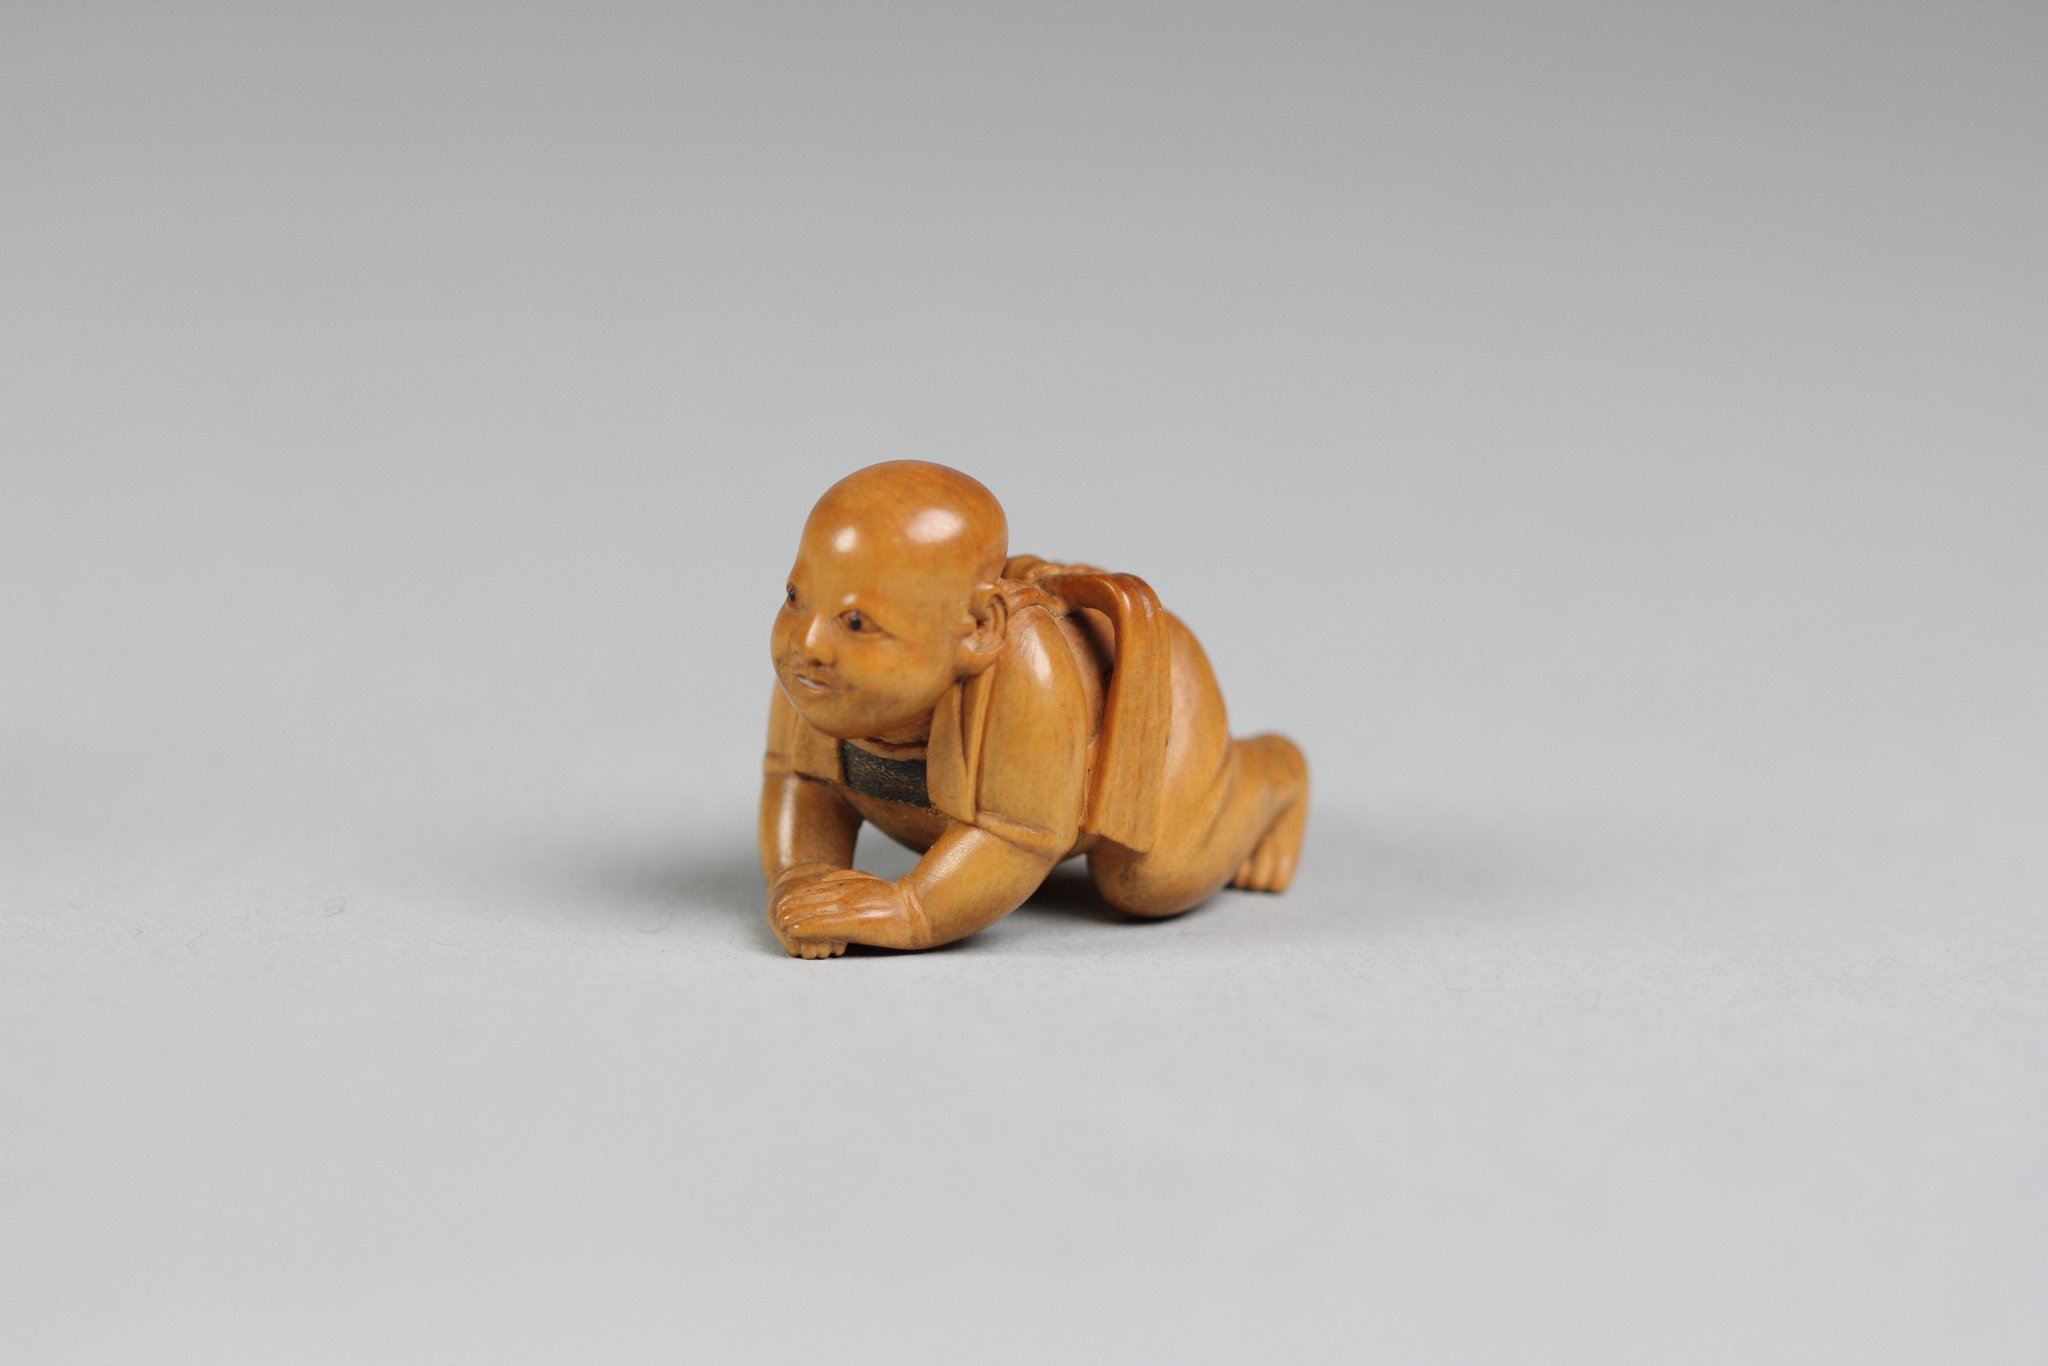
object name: netsuke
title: Netsuke of Crawling Child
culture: japanese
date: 1701-1800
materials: wood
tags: children